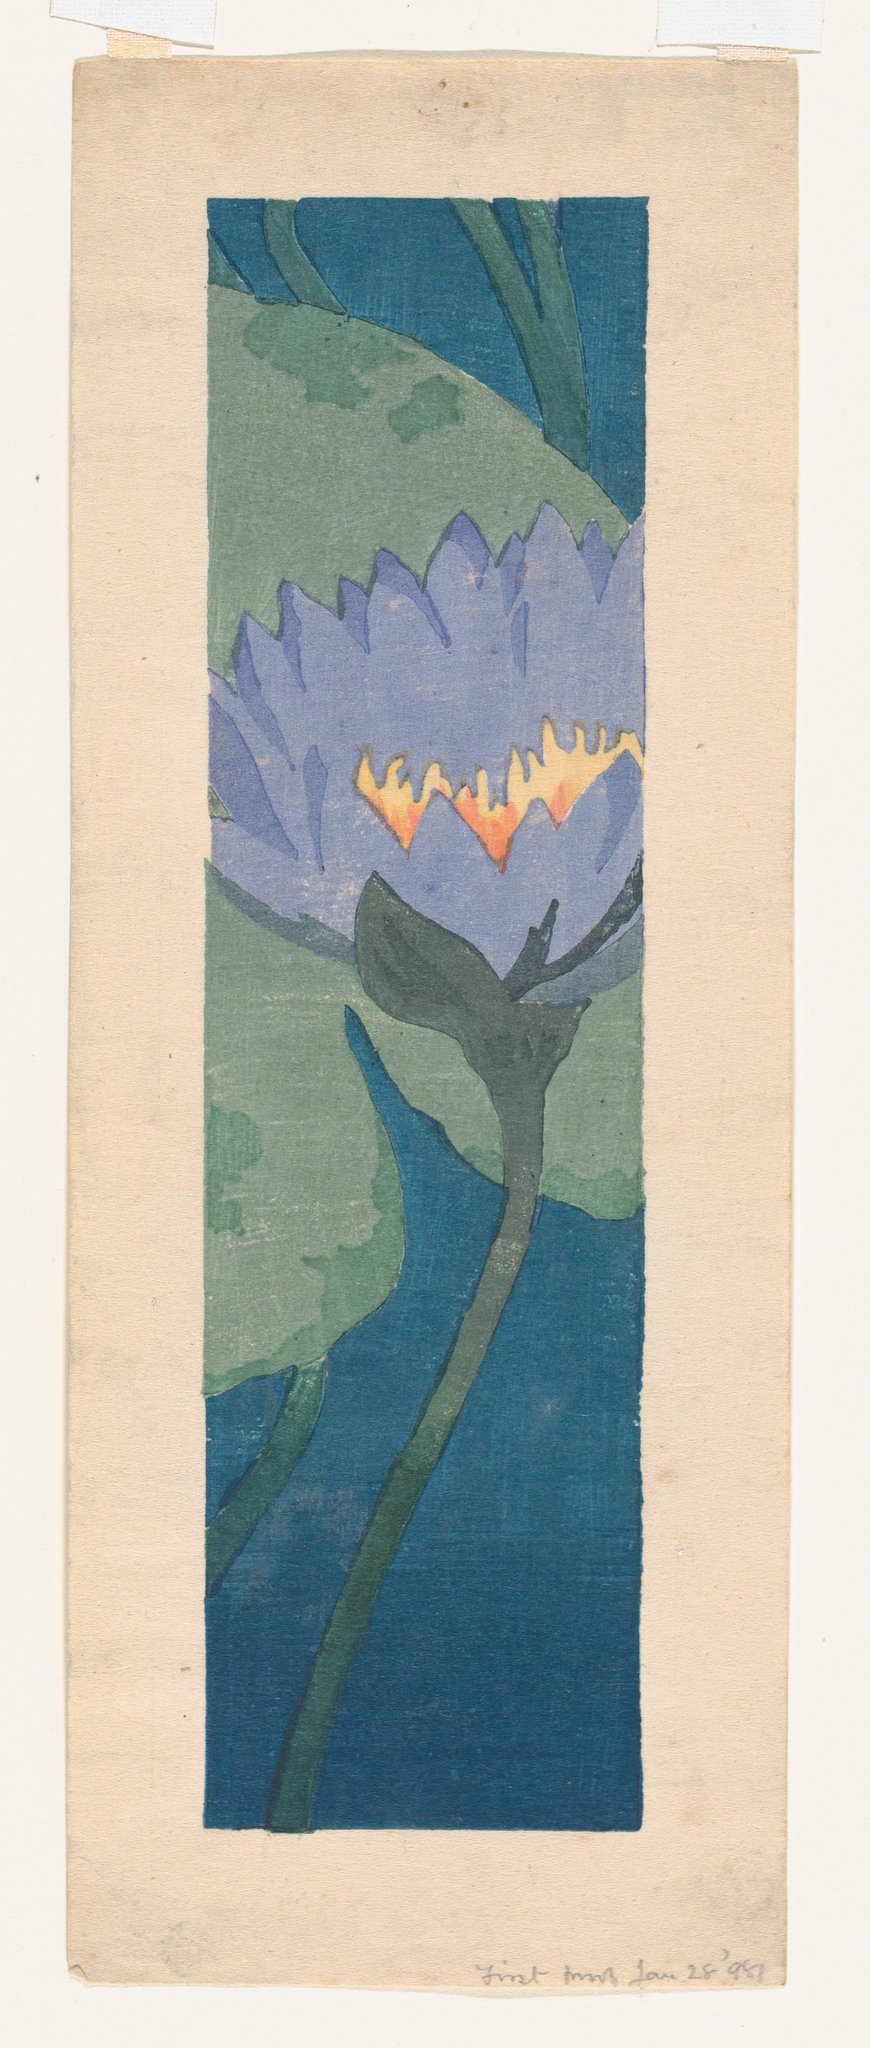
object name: woodcut, print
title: Lily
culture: american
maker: arthur wesley dow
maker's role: artist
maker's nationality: american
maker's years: 1857-1922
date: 1898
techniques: woodcut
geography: united states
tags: lilies